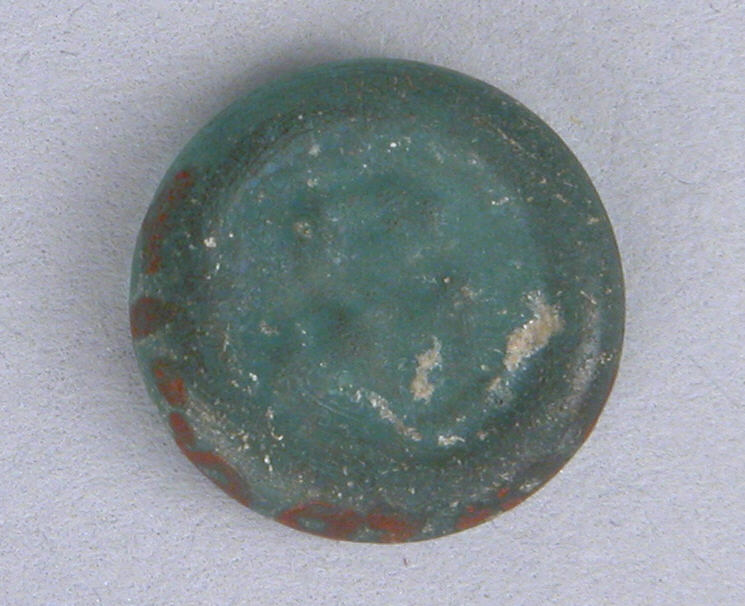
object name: coin weight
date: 901-1200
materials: glass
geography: egypt